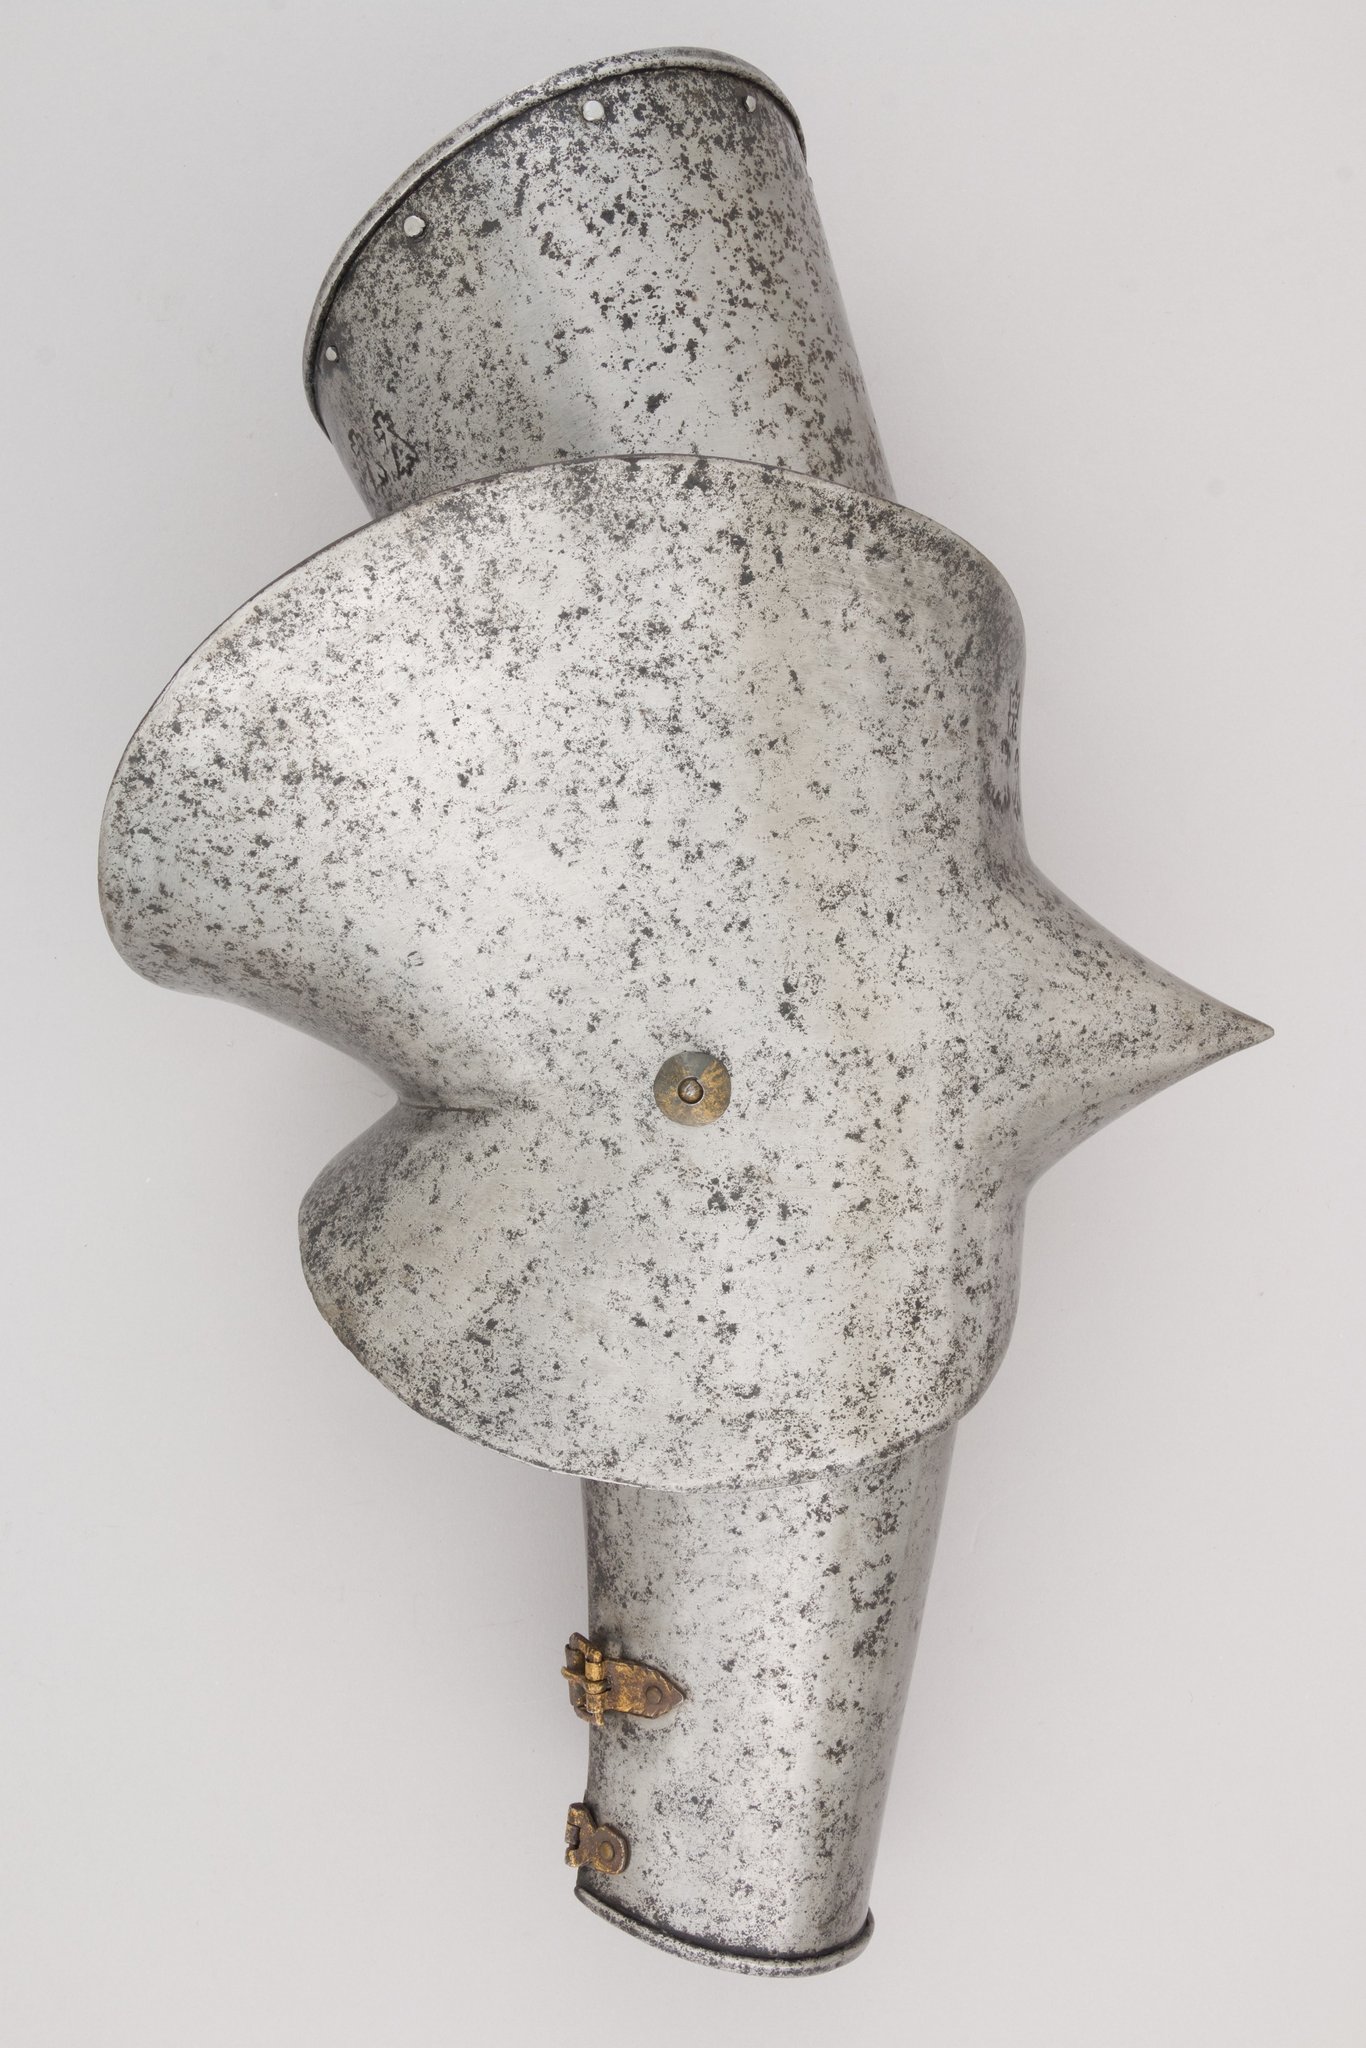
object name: left arm defense vambrace with elbow reinforce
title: Left Arm Defense (Vambrace) with Elbow Reinforce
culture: italian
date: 1450-1460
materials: steel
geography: italy